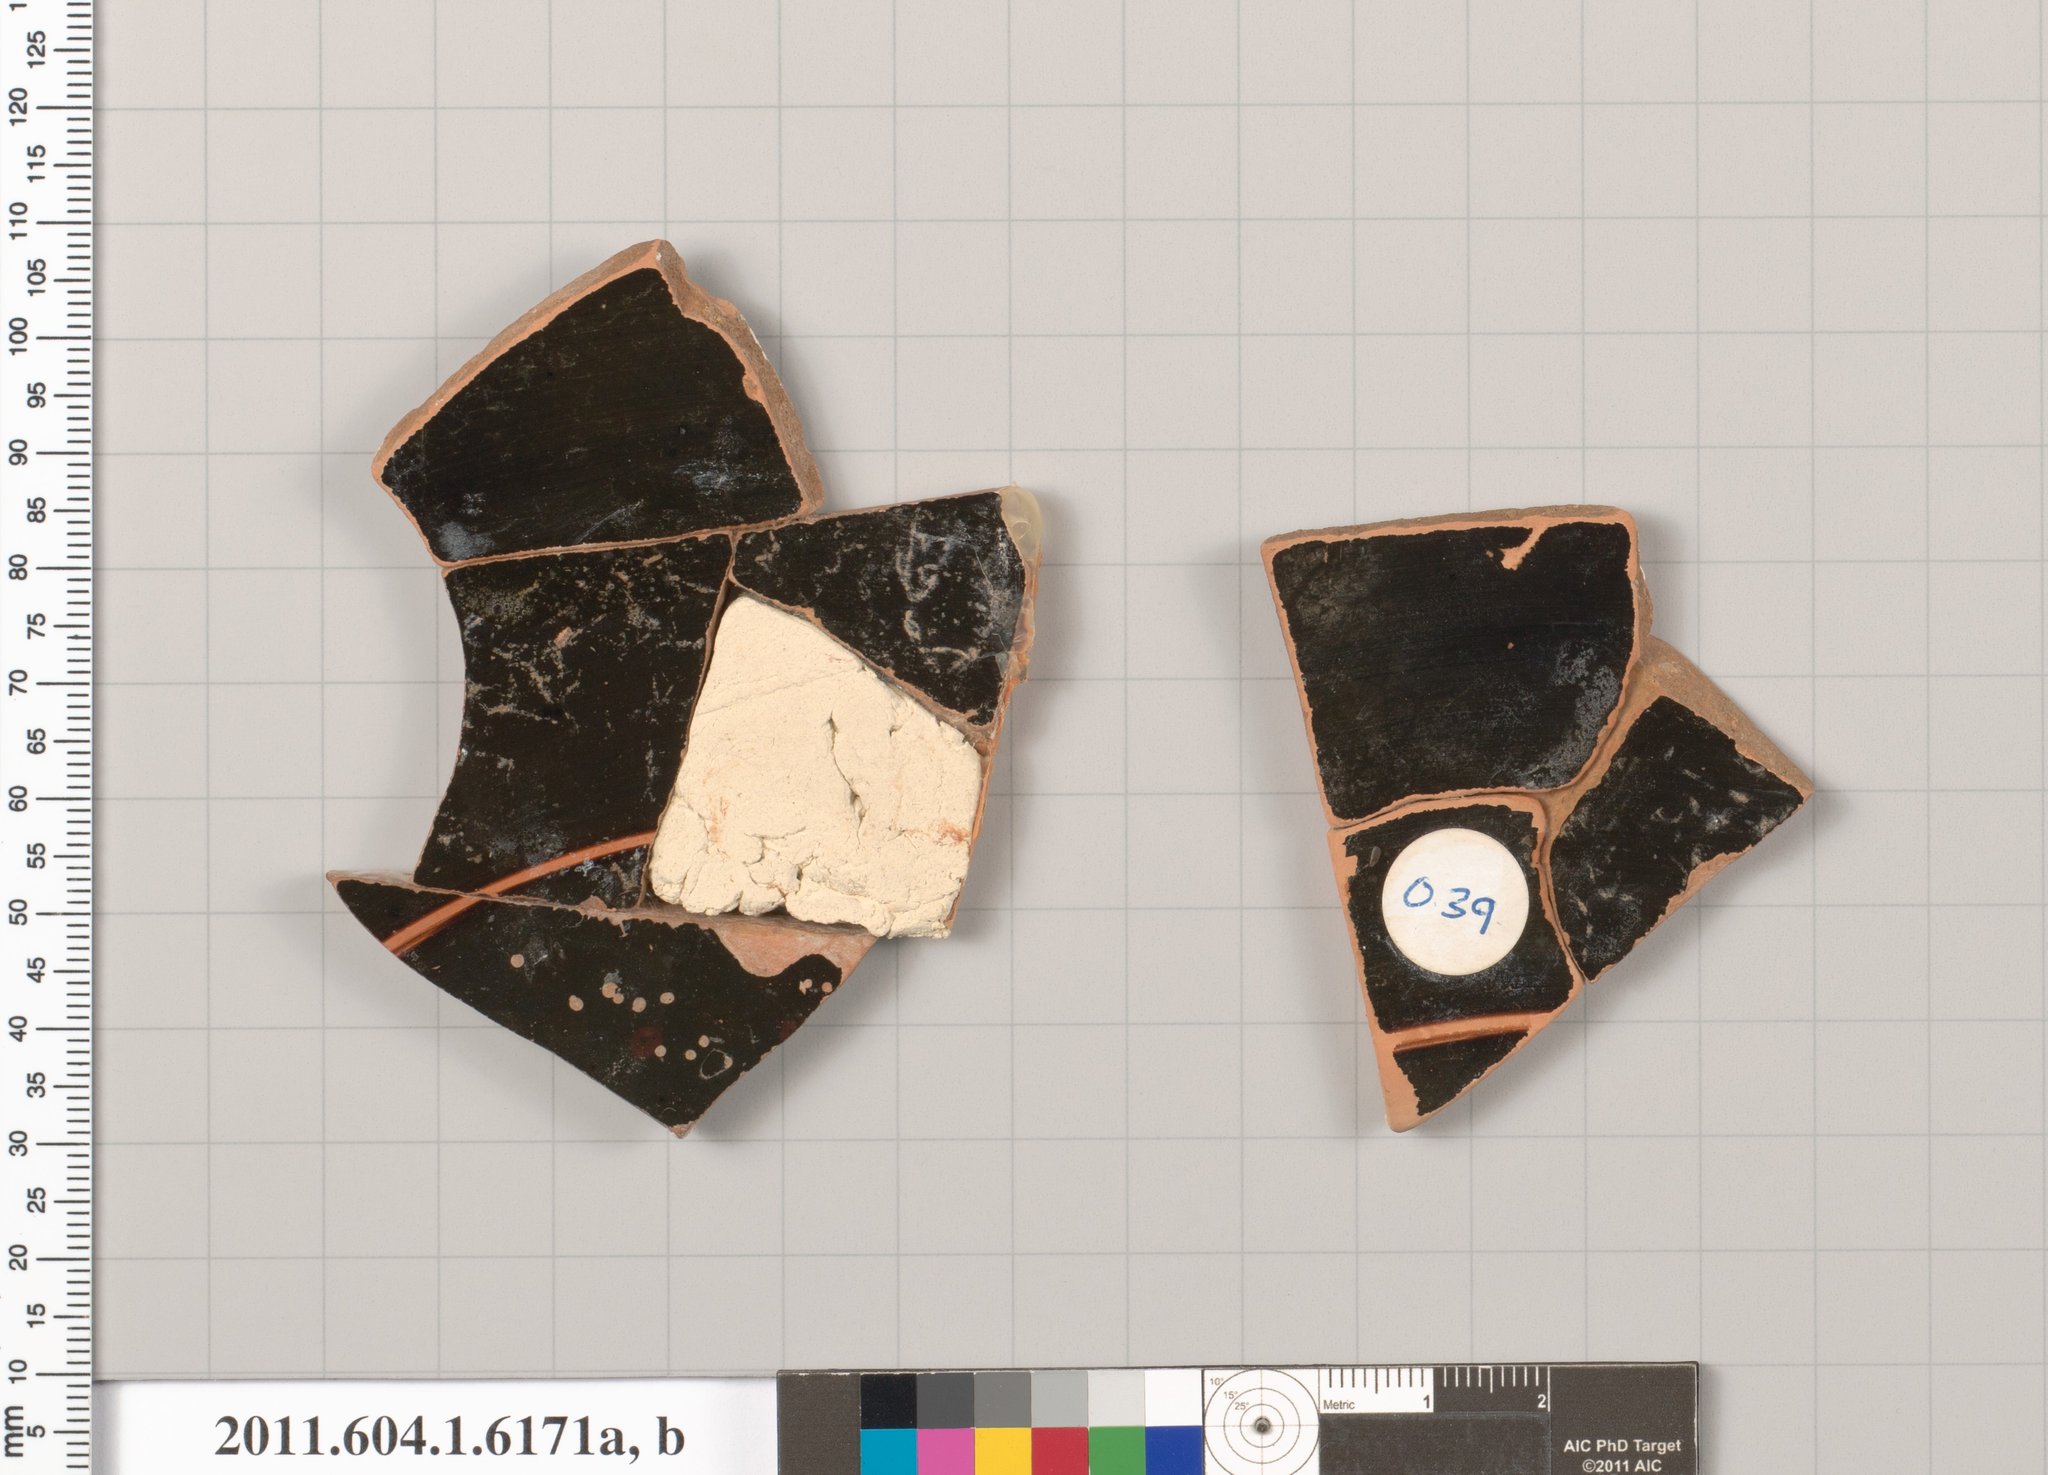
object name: kylix fragment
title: Terracotta fragments of a kylix (drinking cup)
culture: greek, attic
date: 520-500 BCE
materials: terracotta